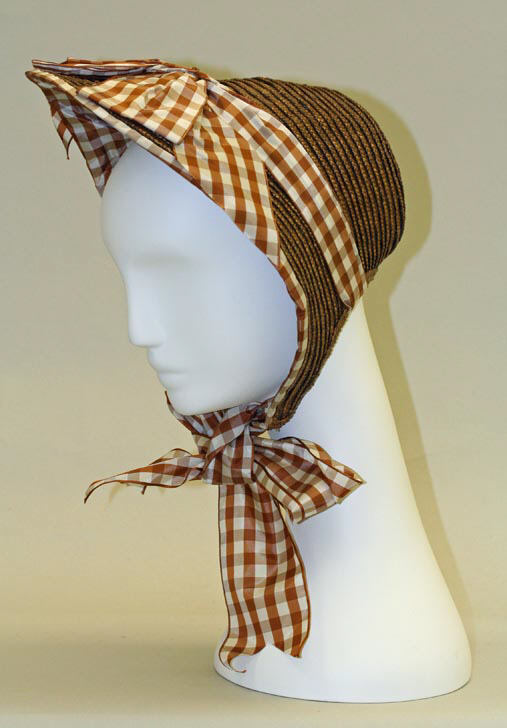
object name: bonnet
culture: american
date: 1858-1862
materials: fiber